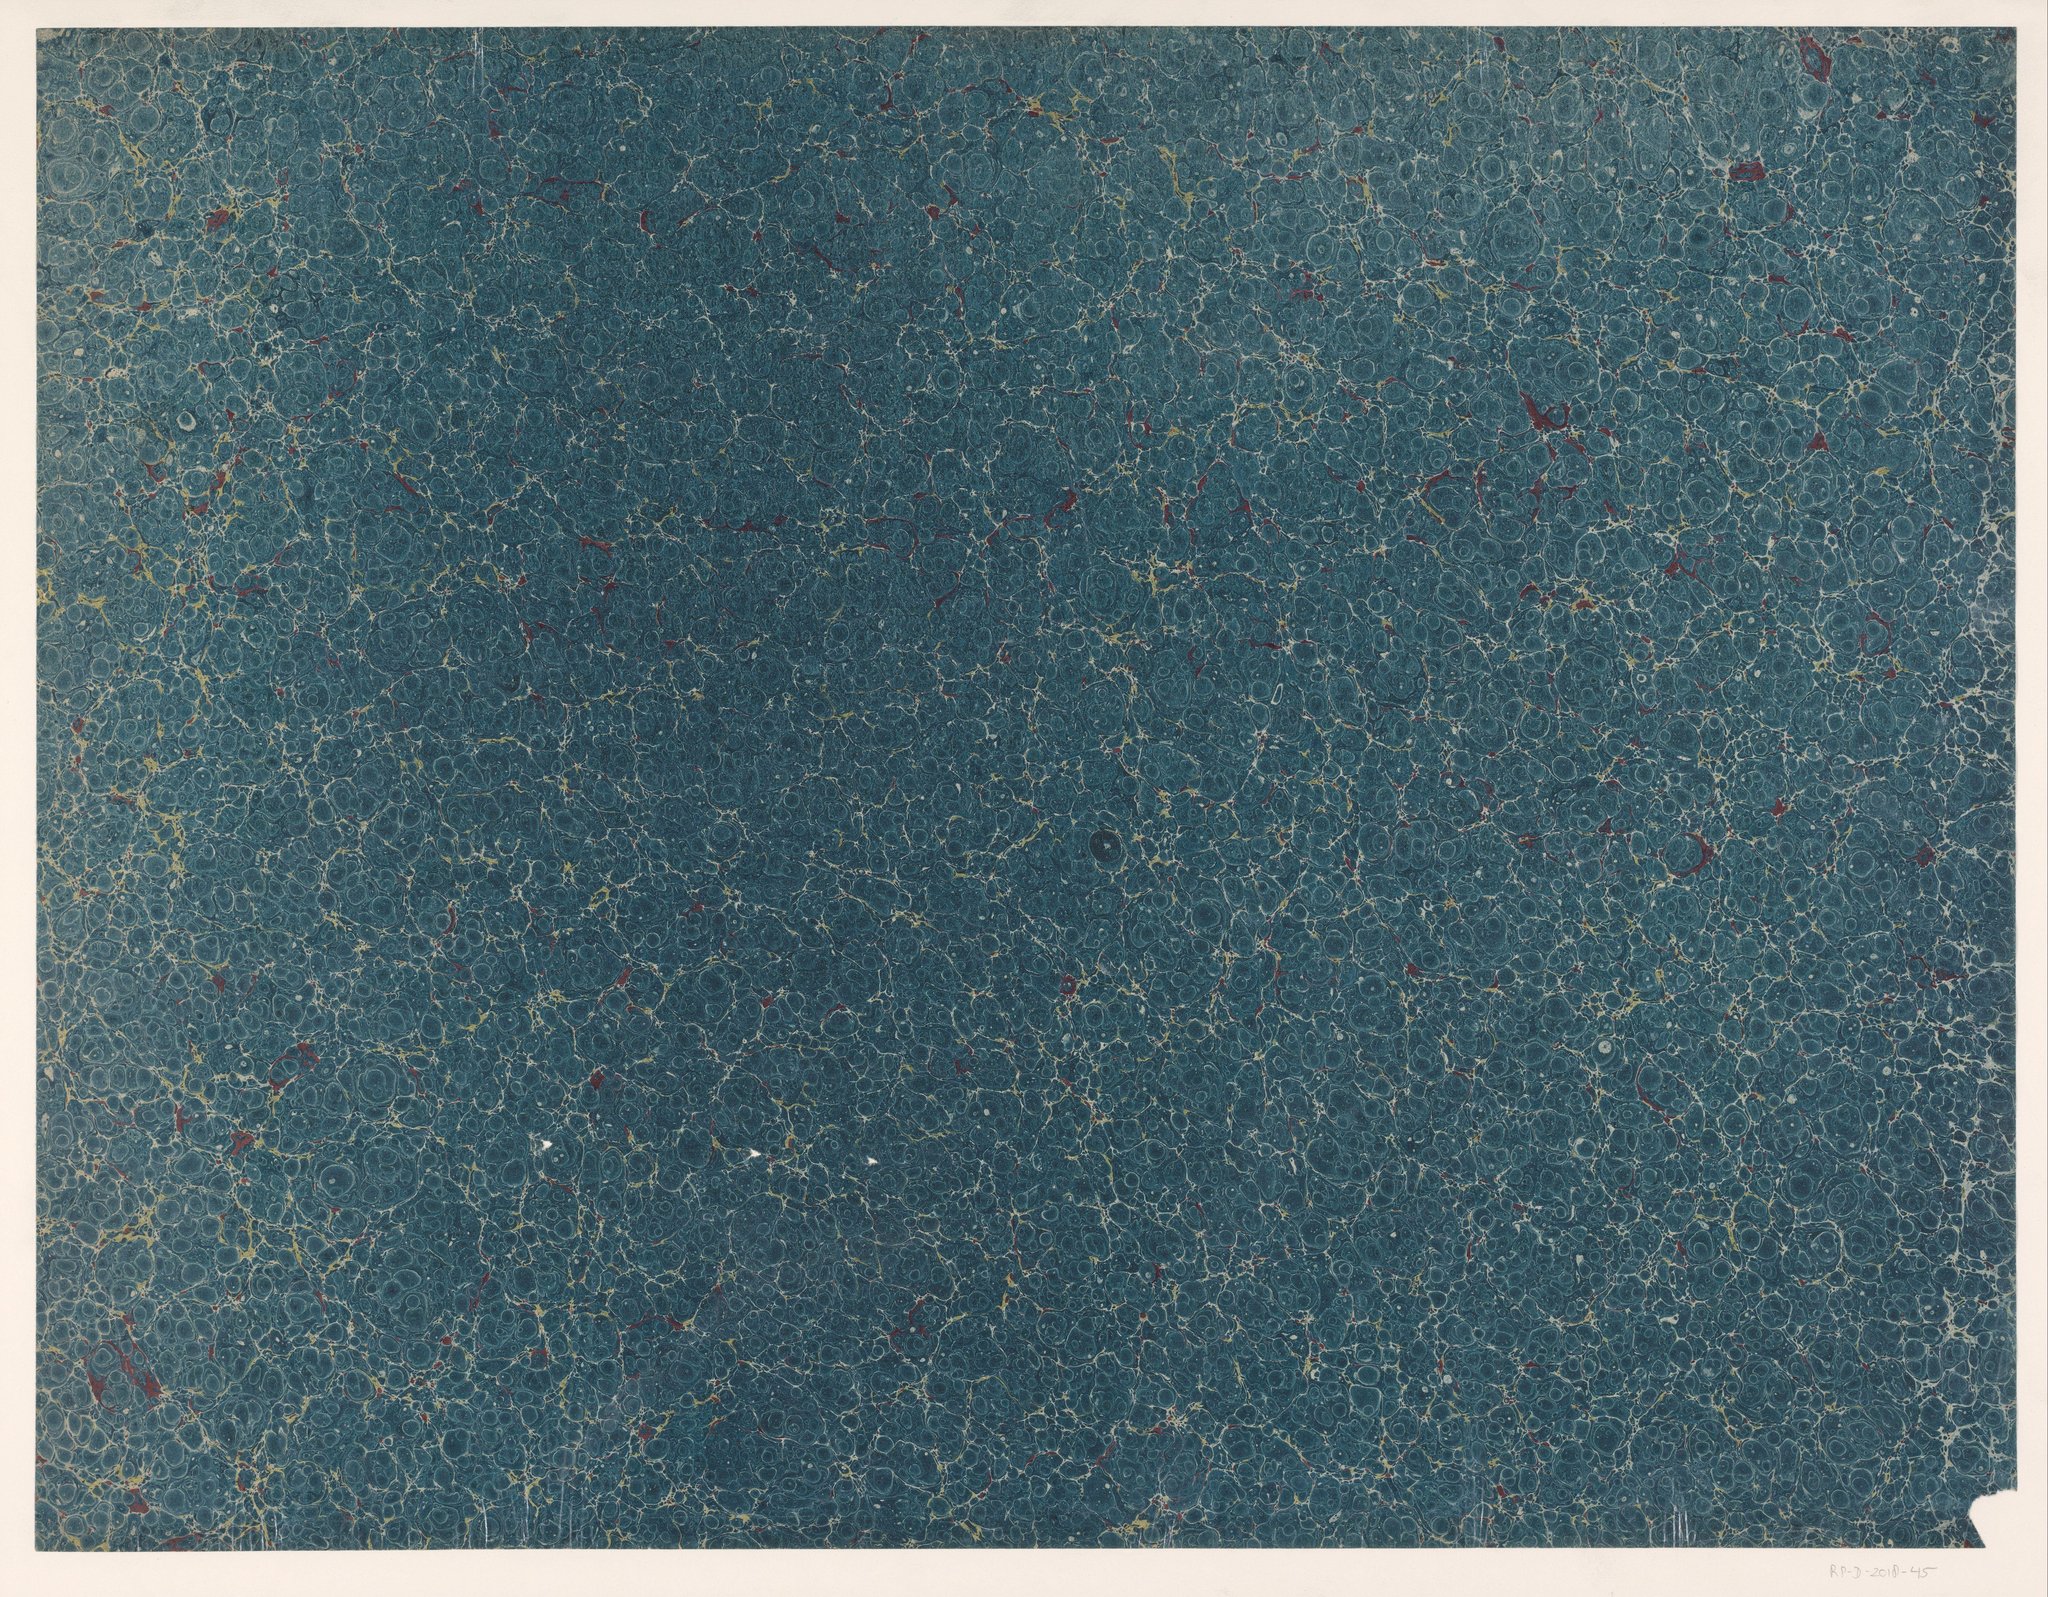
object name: marbled paper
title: Ringkiezelmarmer in blauw, rood en geel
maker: Anonymous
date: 1900-2000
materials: lacquer, paint, paper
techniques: marbled paper